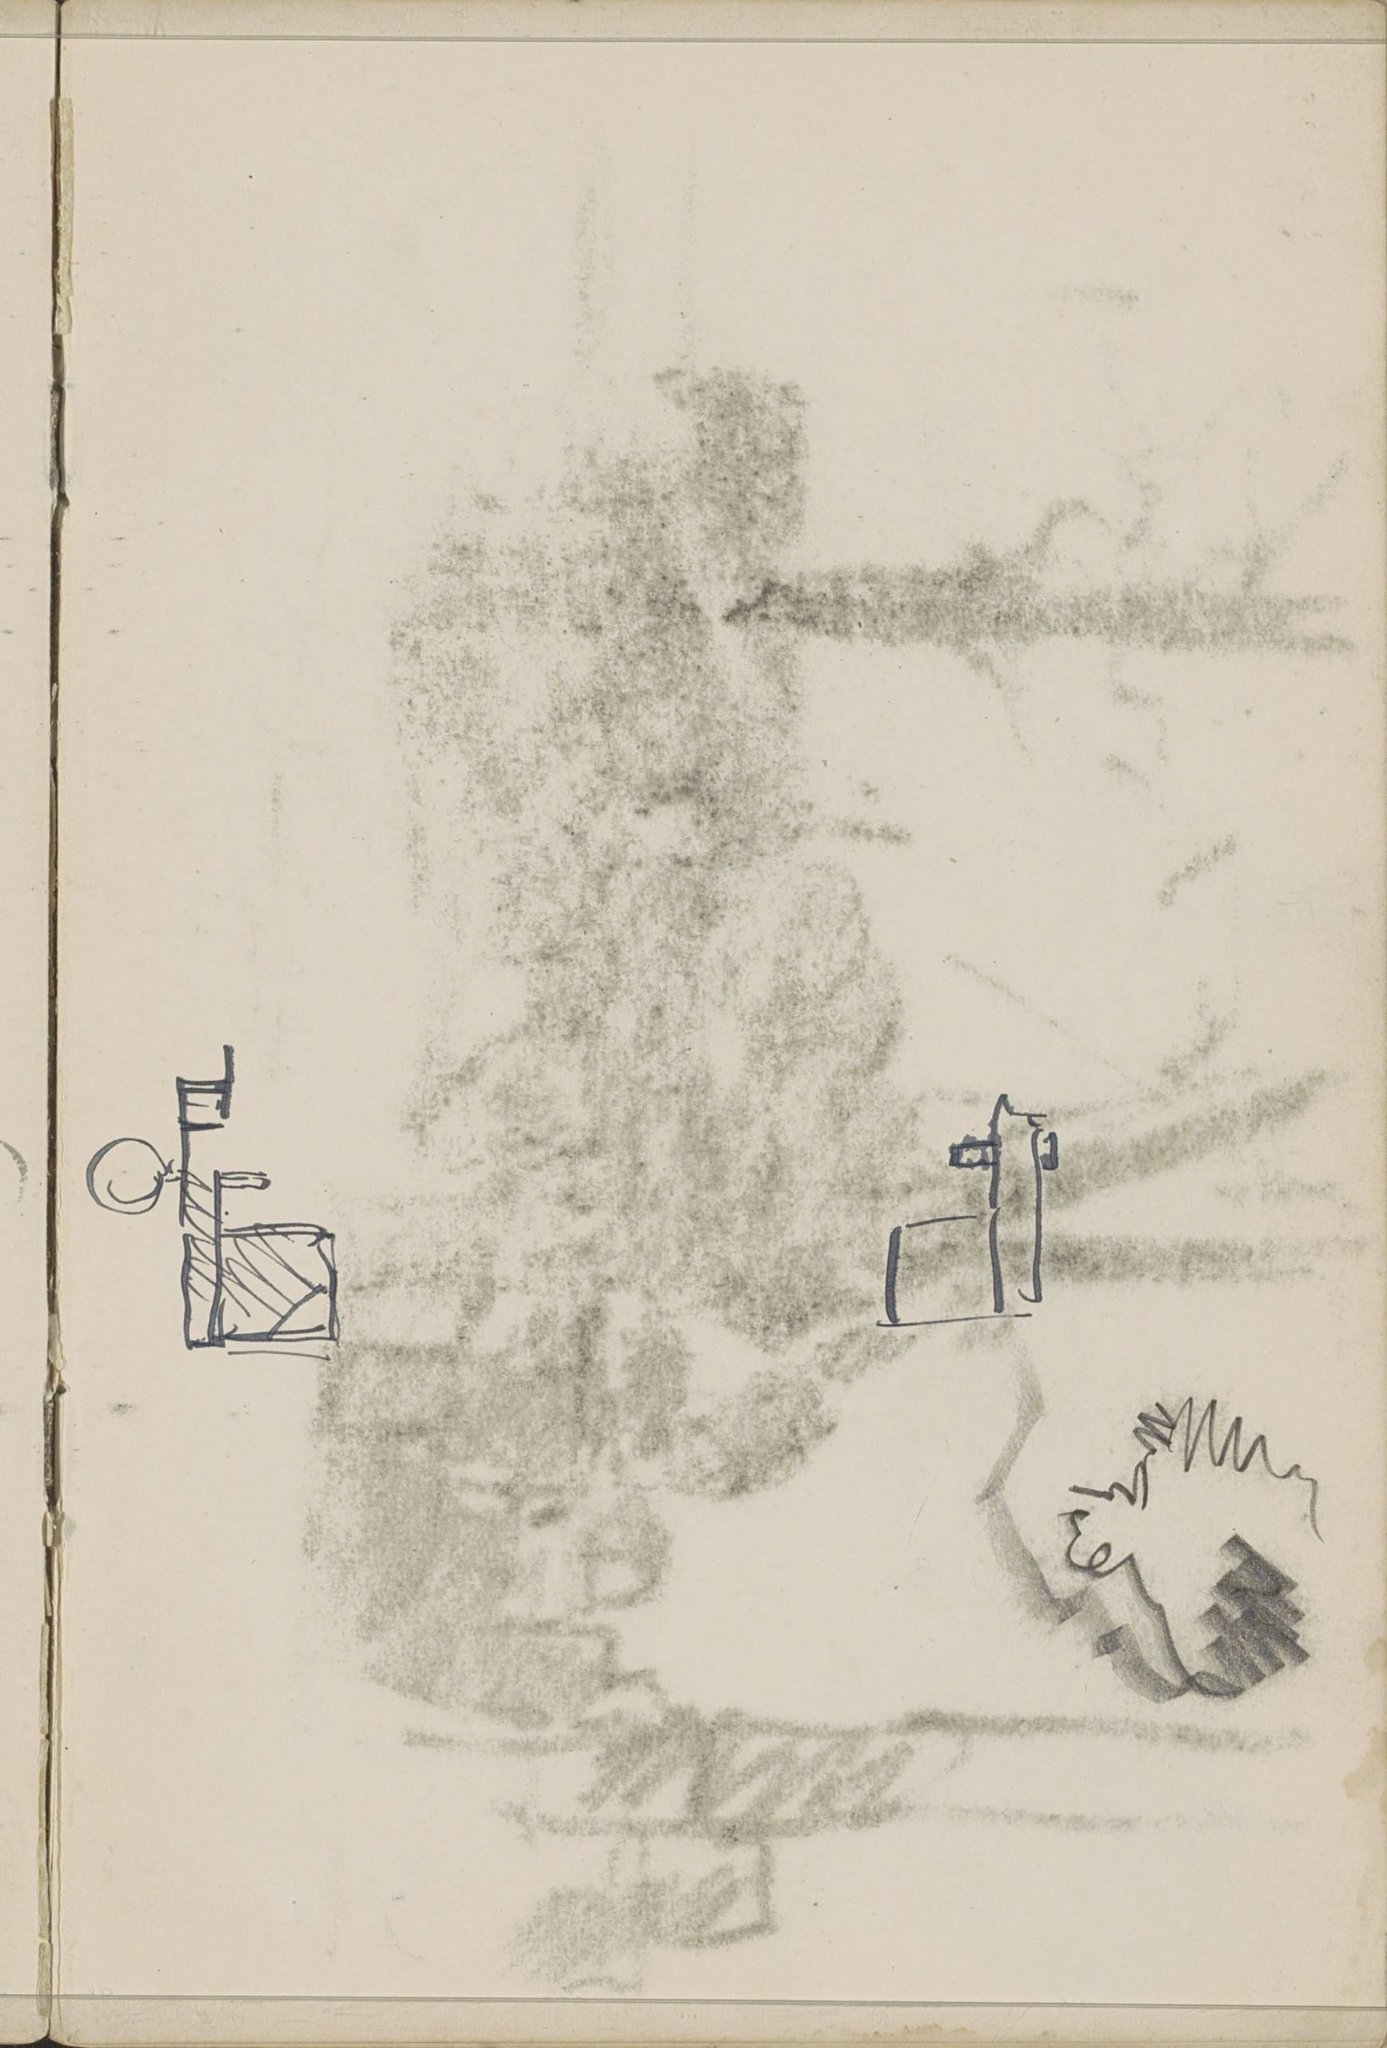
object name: sketchbook leaf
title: Studies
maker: cornelis vreedenburgh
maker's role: draughtsman, print maker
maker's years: 1880-1946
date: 1890-1946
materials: ink, paper, pencil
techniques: pen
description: Blad 12 recto uit een schetsboek met 47 bladen.